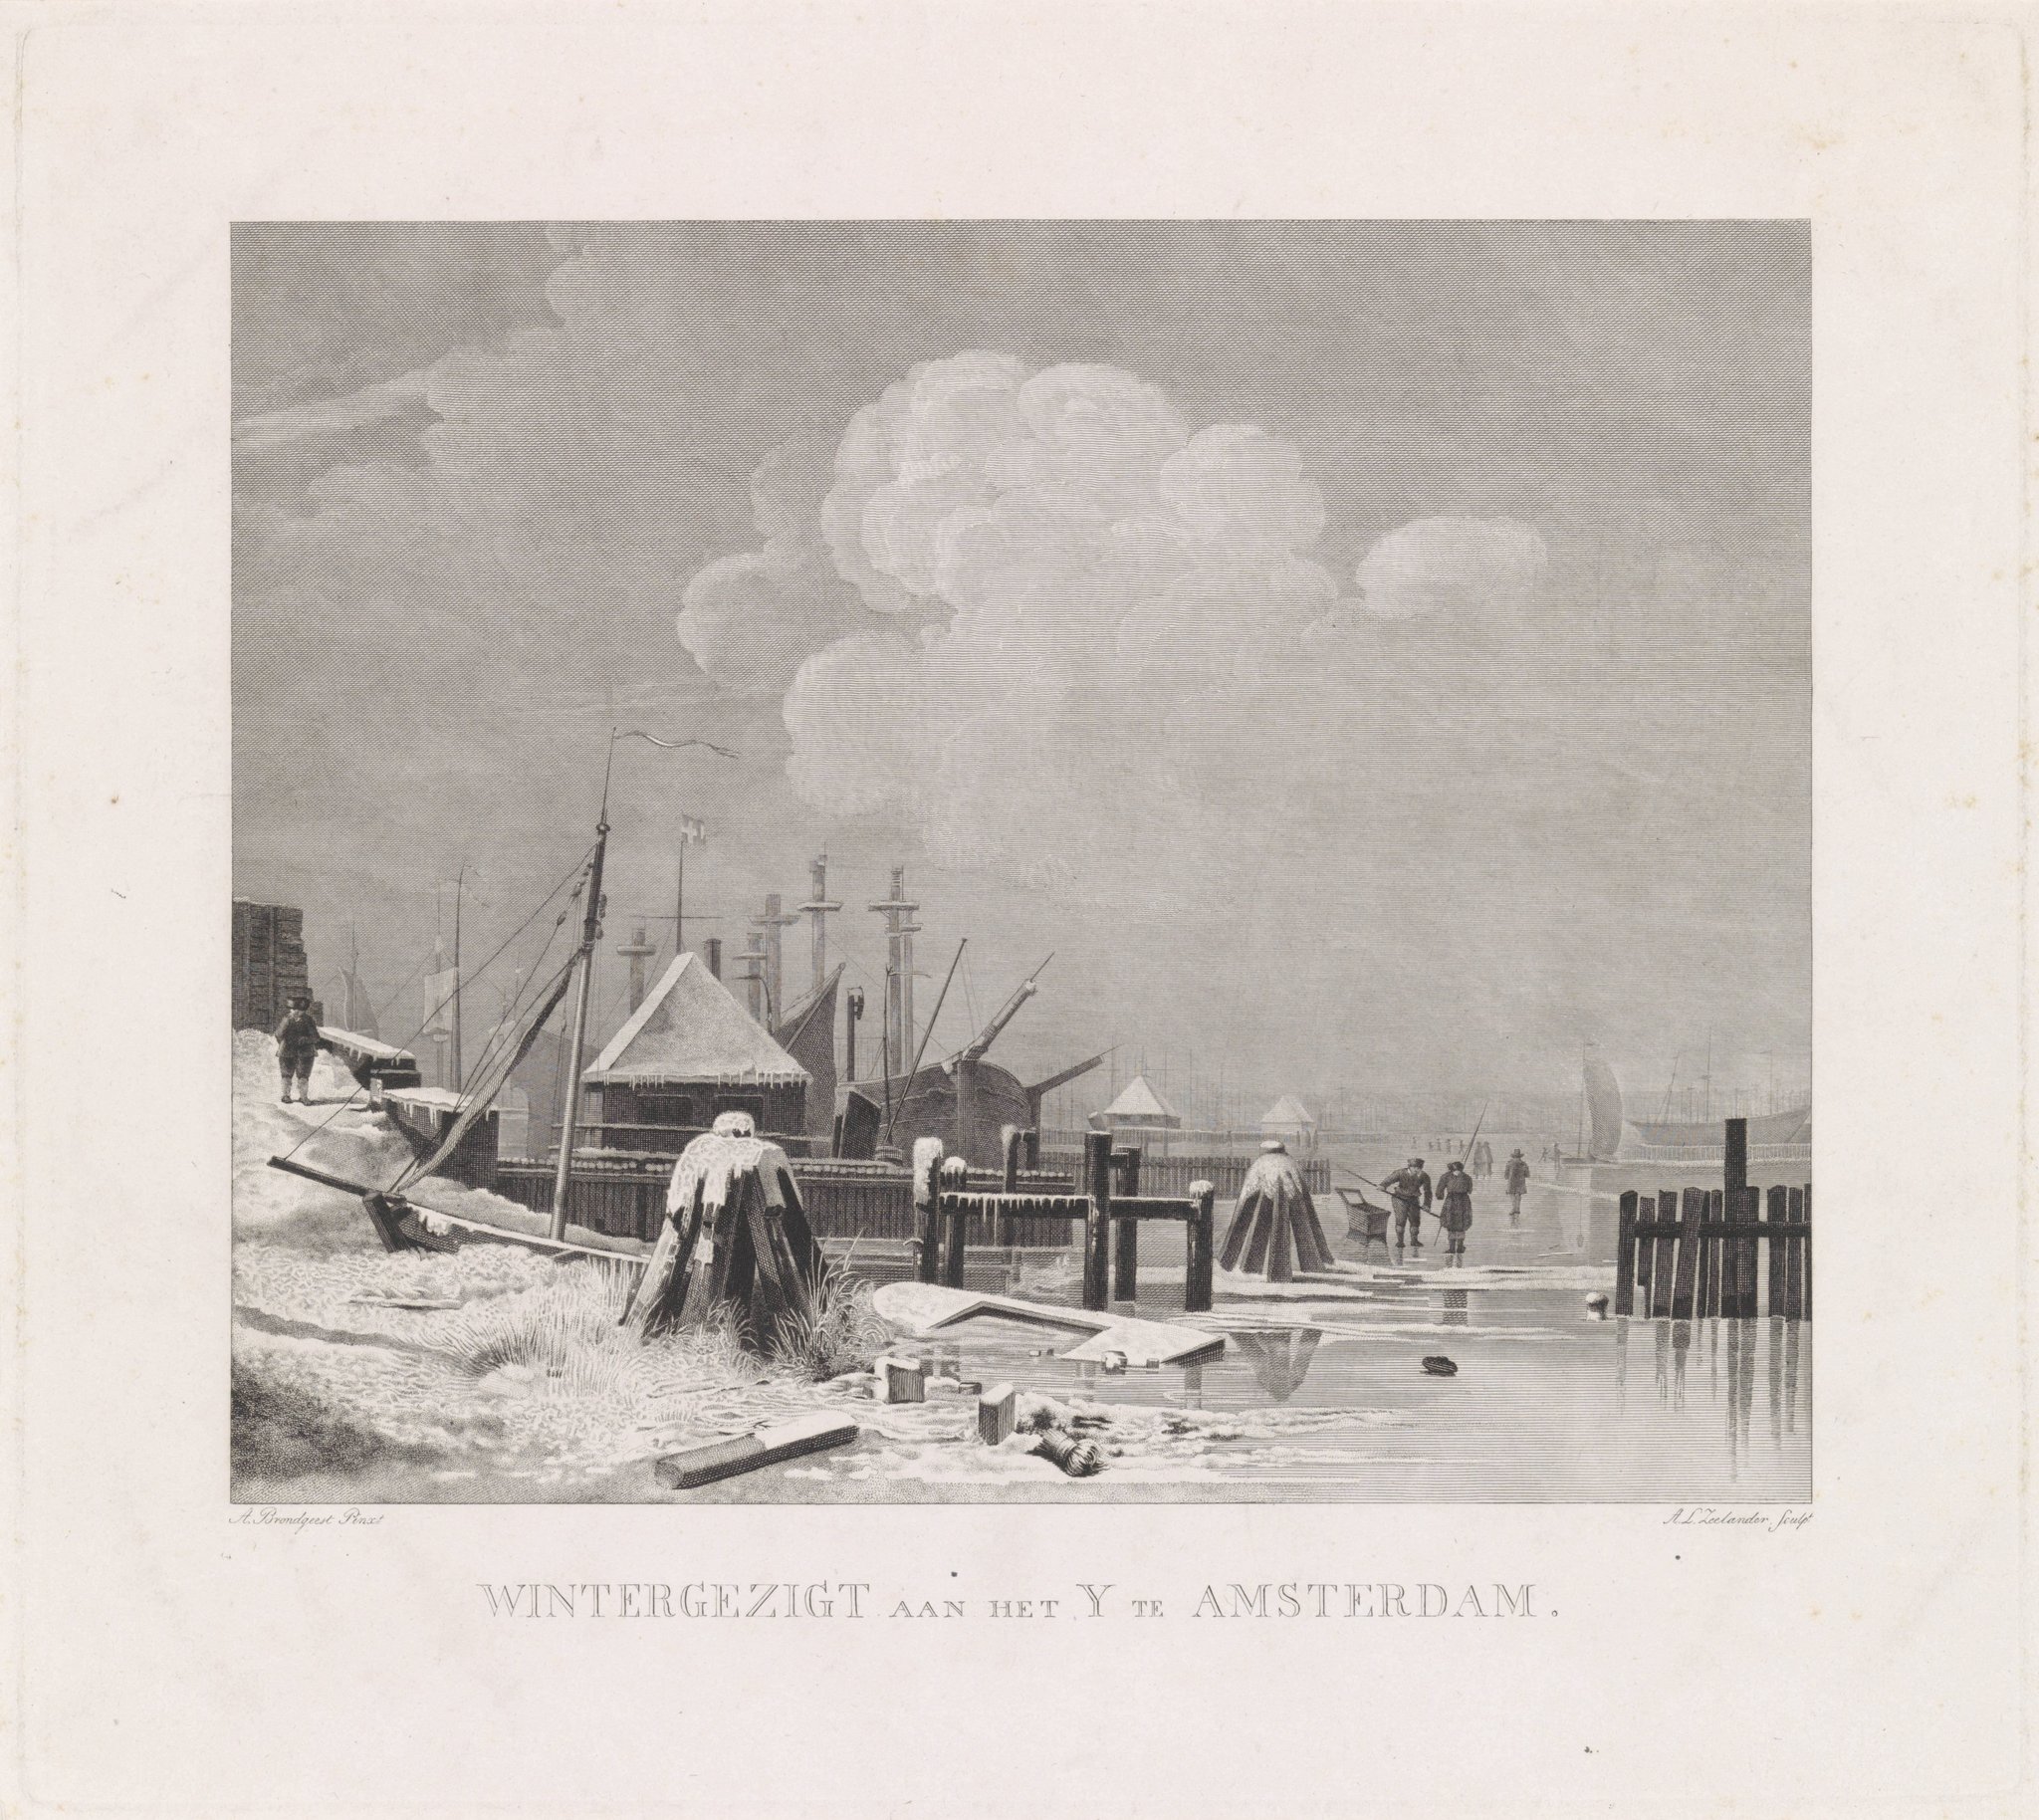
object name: print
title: Wintergezigt aan het Y te Amsterdam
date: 1799-1856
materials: paper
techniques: engraving, etching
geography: amsterdam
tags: winter landscape; landscape symbolizing winter (the four seasons of the year)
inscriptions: collector's mark: Lugt 2228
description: Wintergezicht bij Amsterdam. Mensen lopen op het bevroren IJ. Links een dijk en schepen in het ijs.